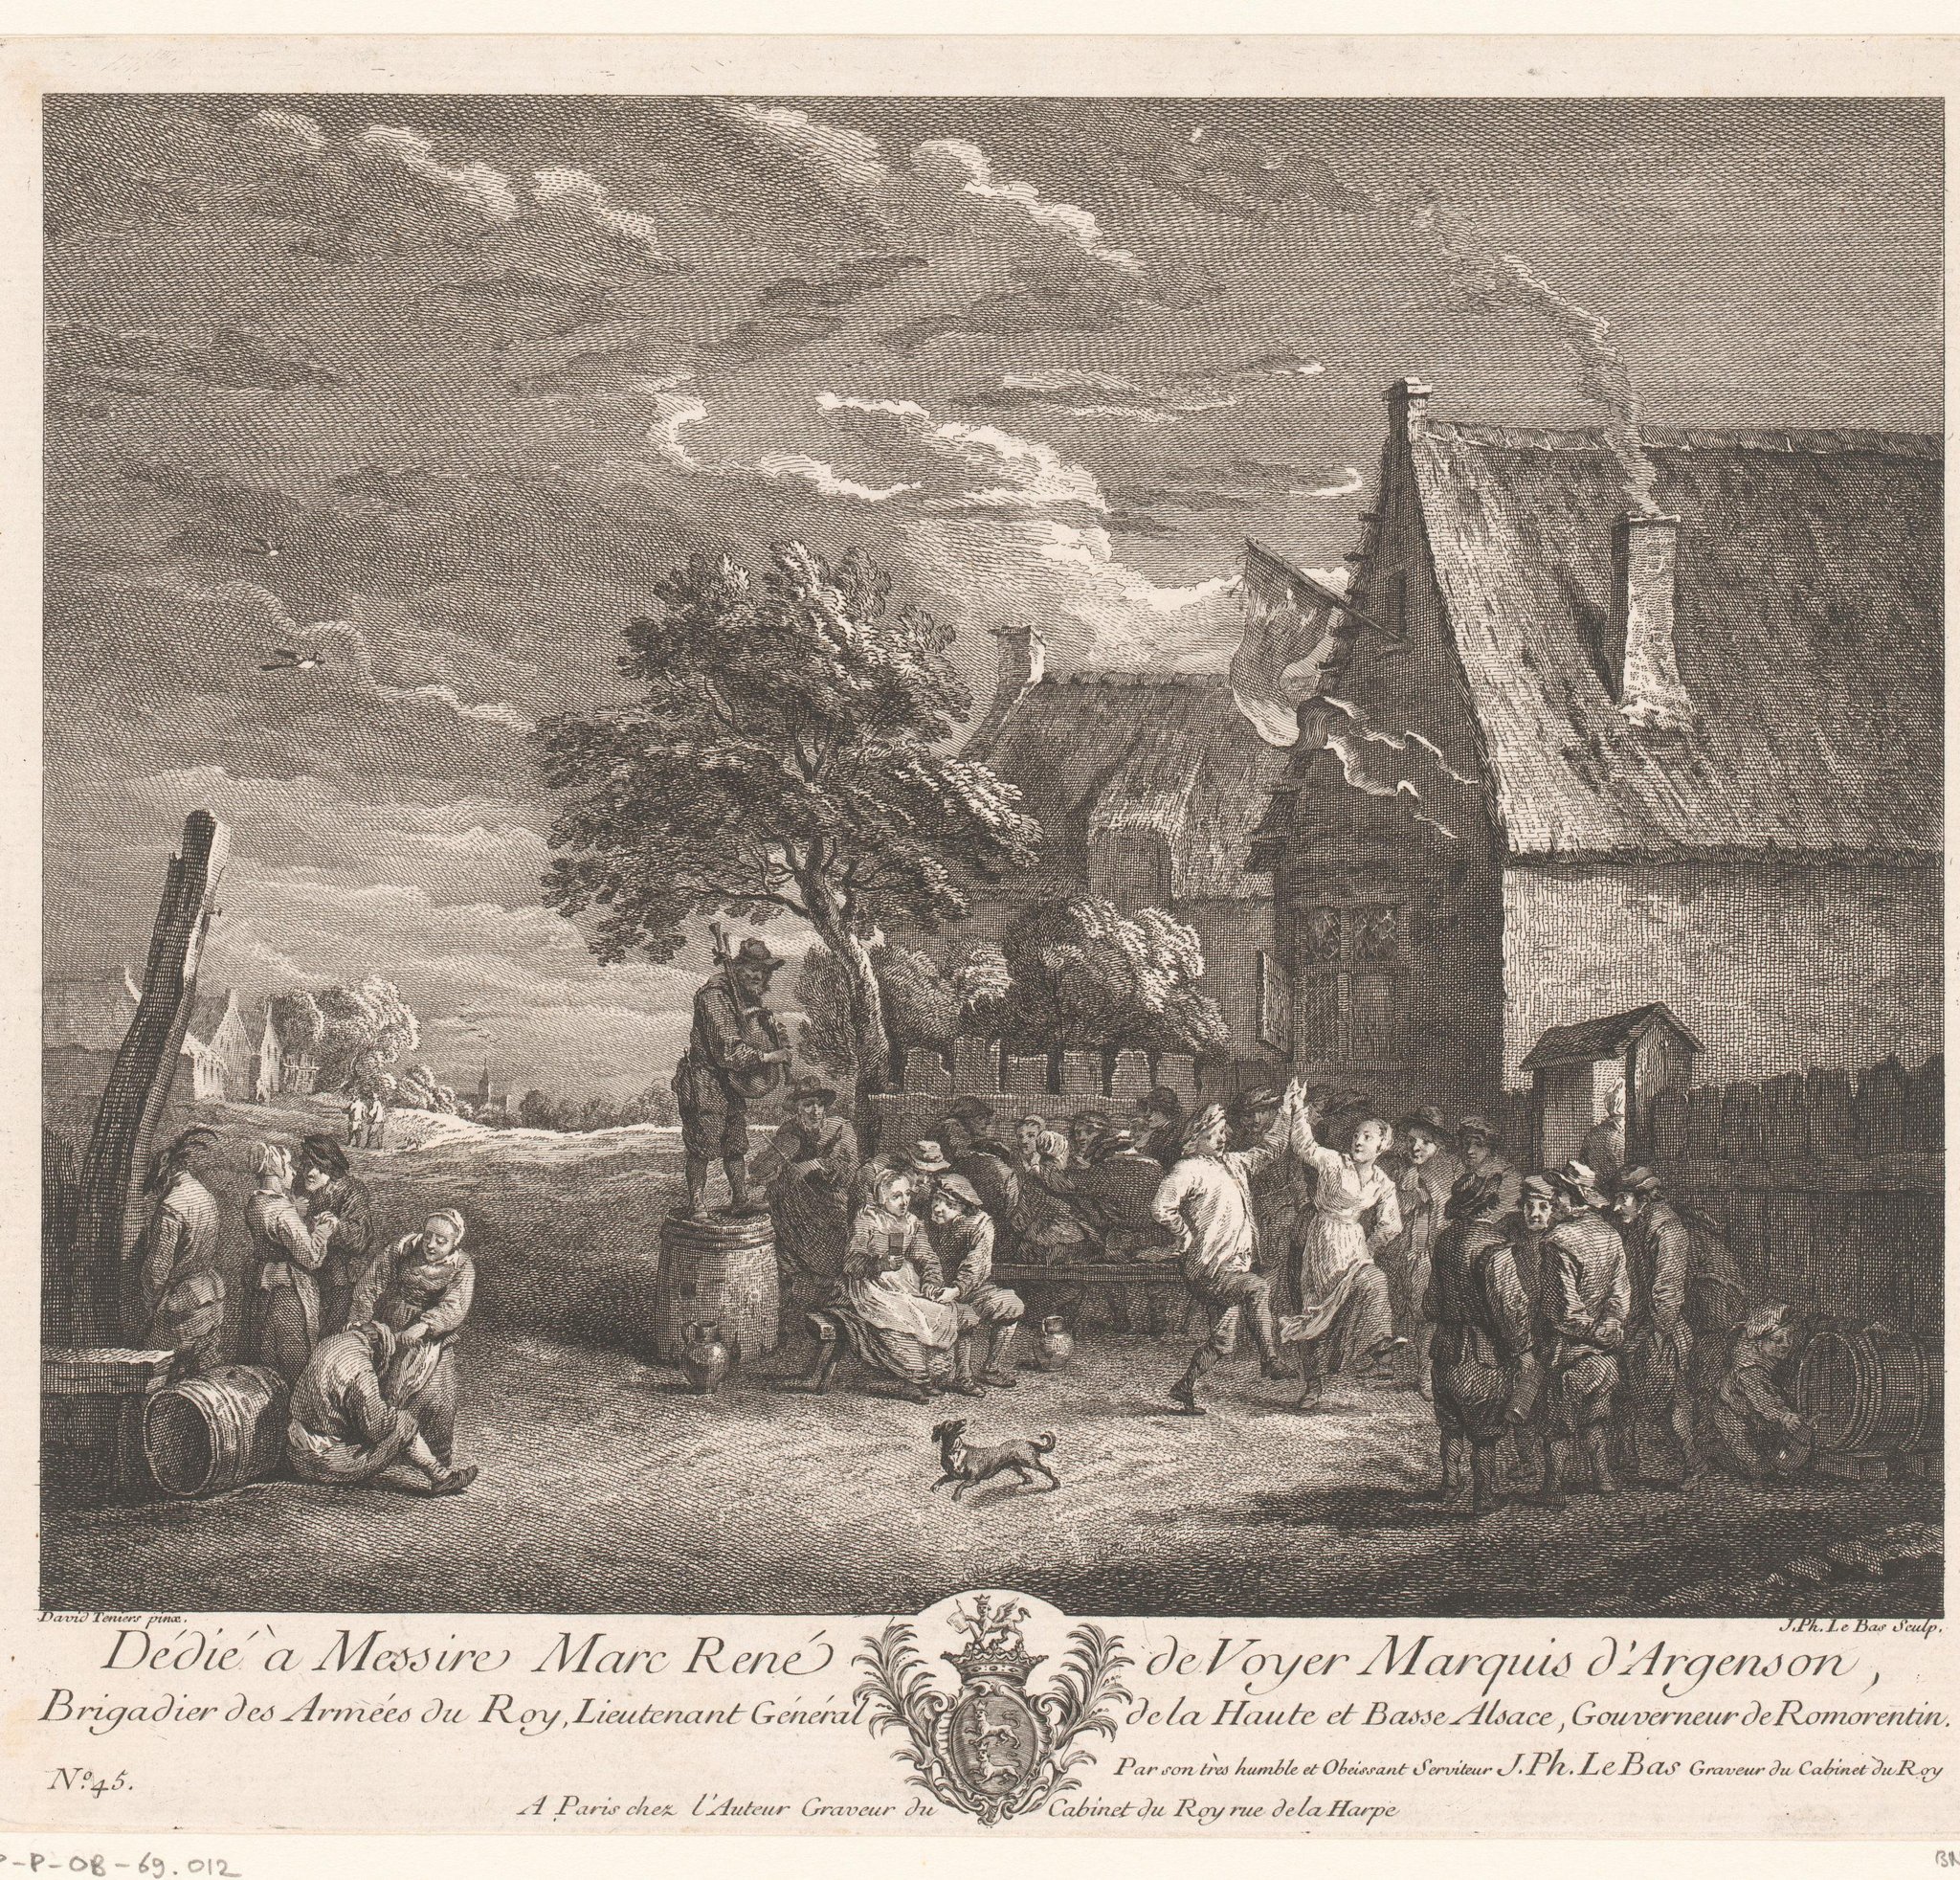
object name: print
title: Boerenfeest voor een herberg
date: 1747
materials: paper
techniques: etching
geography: france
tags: public festivities (+ dancing ~ festive activities), armorial bearing, heraldry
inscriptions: collector's mark: Lugt 240